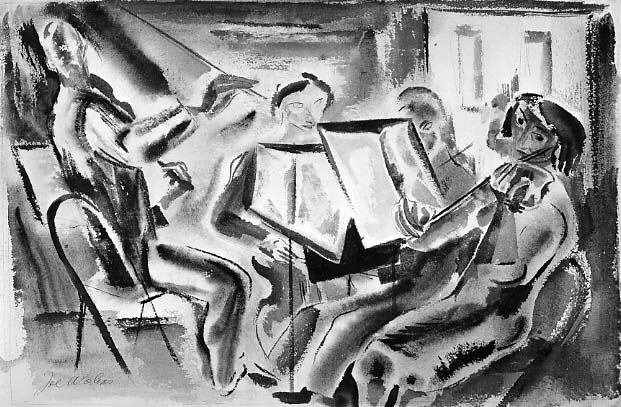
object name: drawing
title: Chamber Music Group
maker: joseph wolins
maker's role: artist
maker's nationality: american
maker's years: 1915-1999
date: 1939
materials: graphite, paper, watercolor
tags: musical instruments,men,music,musicians